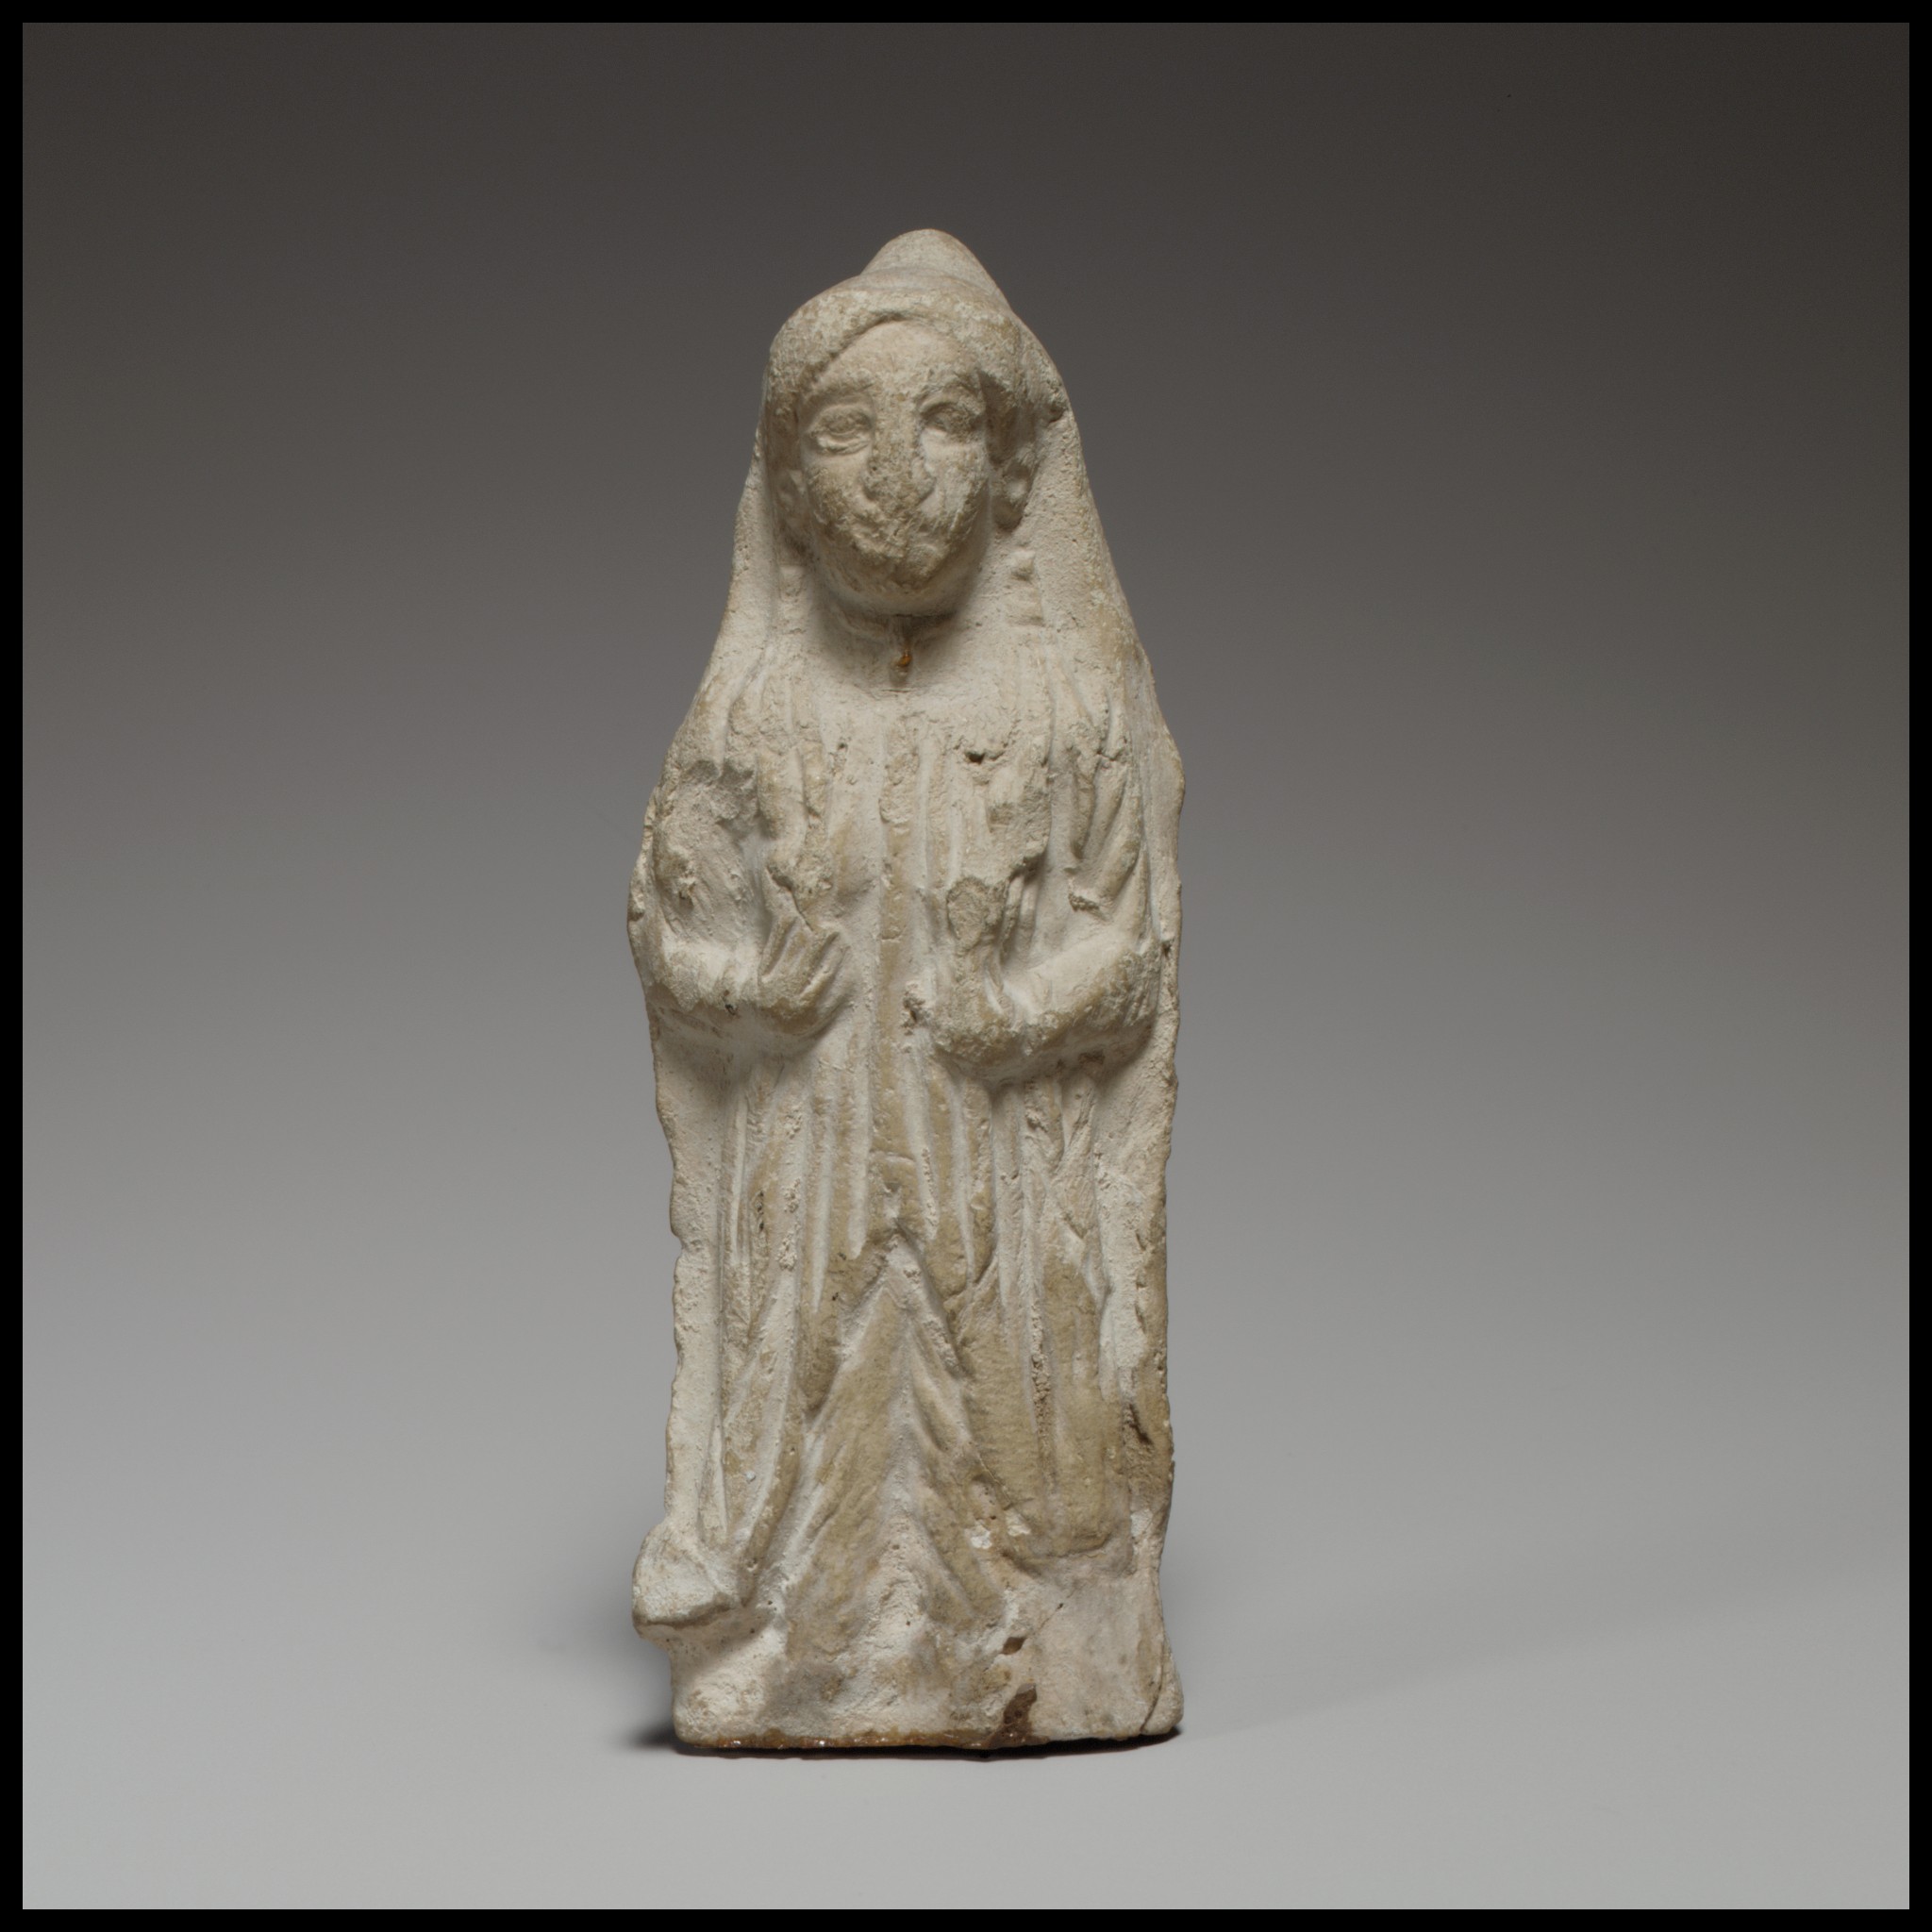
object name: statuette of a female from a ring dance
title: Standing female figurine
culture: cypriot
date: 500-468 BCE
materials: terracotta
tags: women